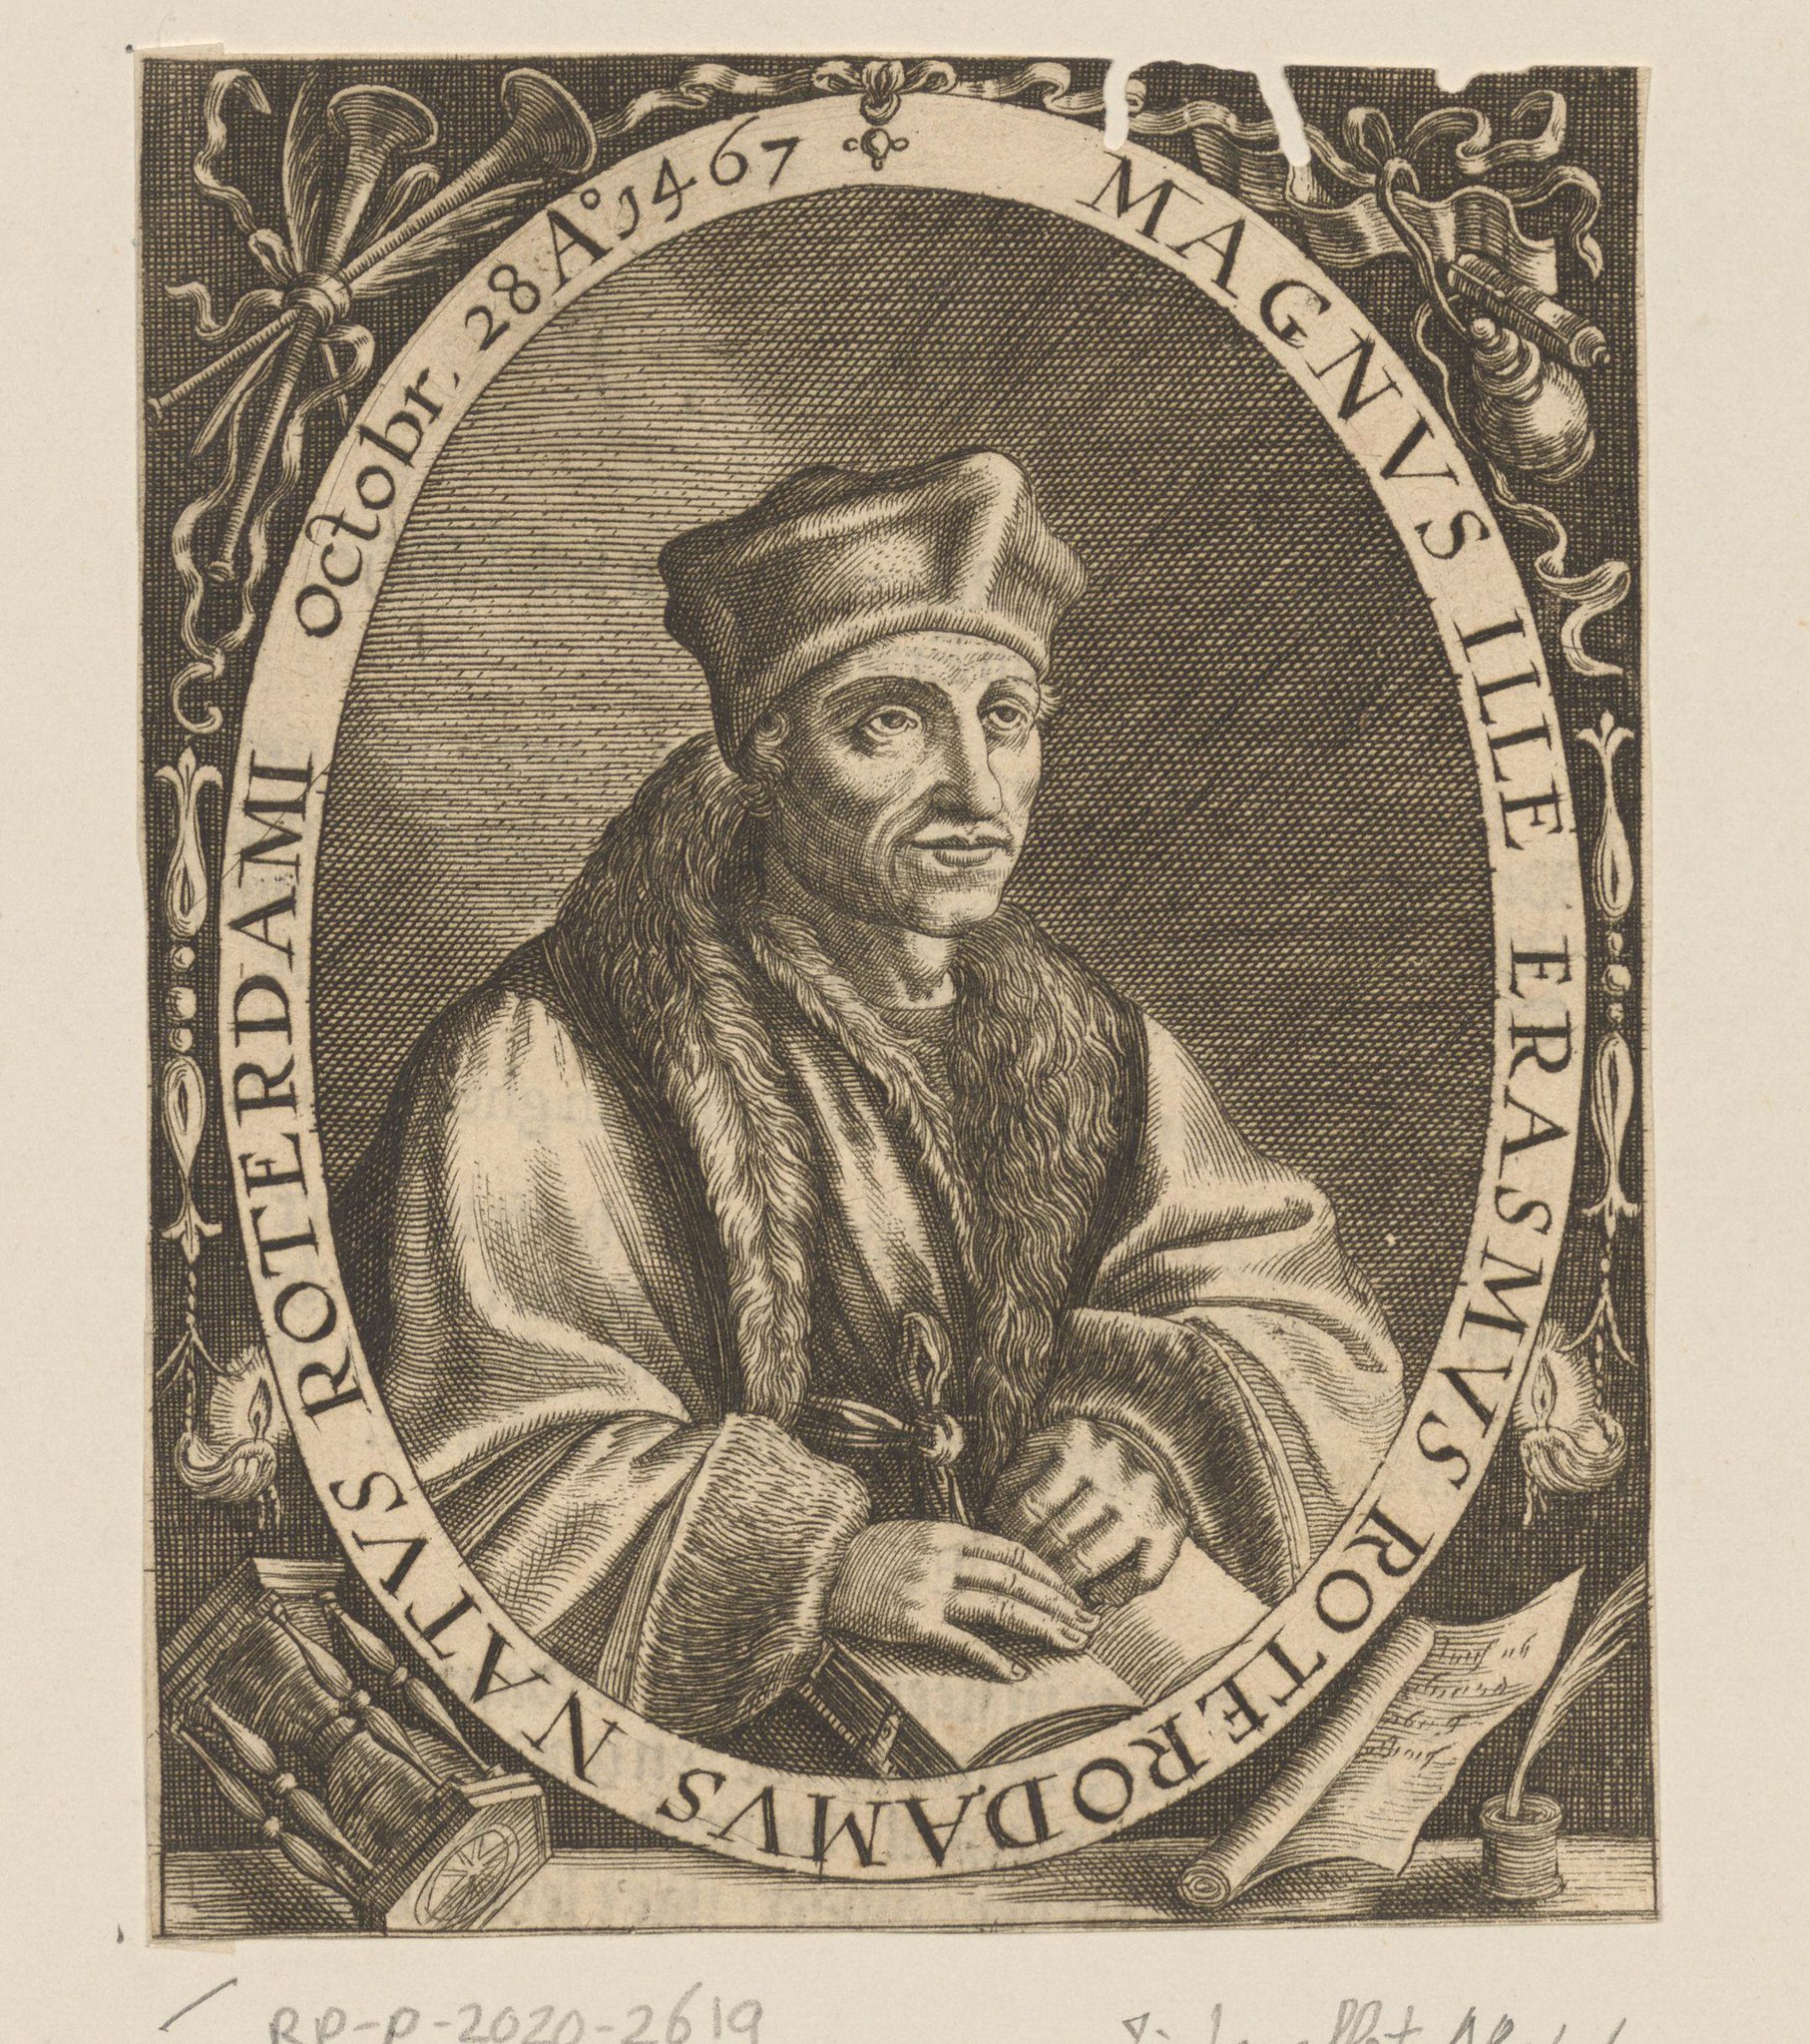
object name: print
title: Portret van Desiderius Erasmus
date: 1616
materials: paper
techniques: engraving, letterpress printing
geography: northern netherlands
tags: rotterdam, desiderius erasmus, historical persons, book - mm - book open, hourglass, scholar, philosopher (+ portrait of scholar, scientist)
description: Prent uit: Bastiaensz. Matthijs. Opuscula Desiderii Erasmi Roterodami (...). Rotterdam: Matthijs Bastiaensz., 1616.